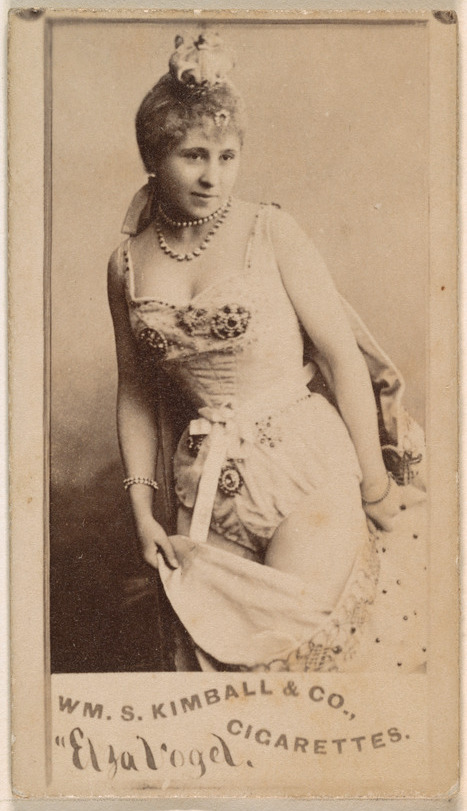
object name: photograph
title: Elza Vogel, from the Actresses series (N203) issued by Wm. S. Kimball & Co.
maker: william s. kimball & company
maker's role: publisher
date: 1889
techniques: color lithograph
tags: portraits,women,actresses